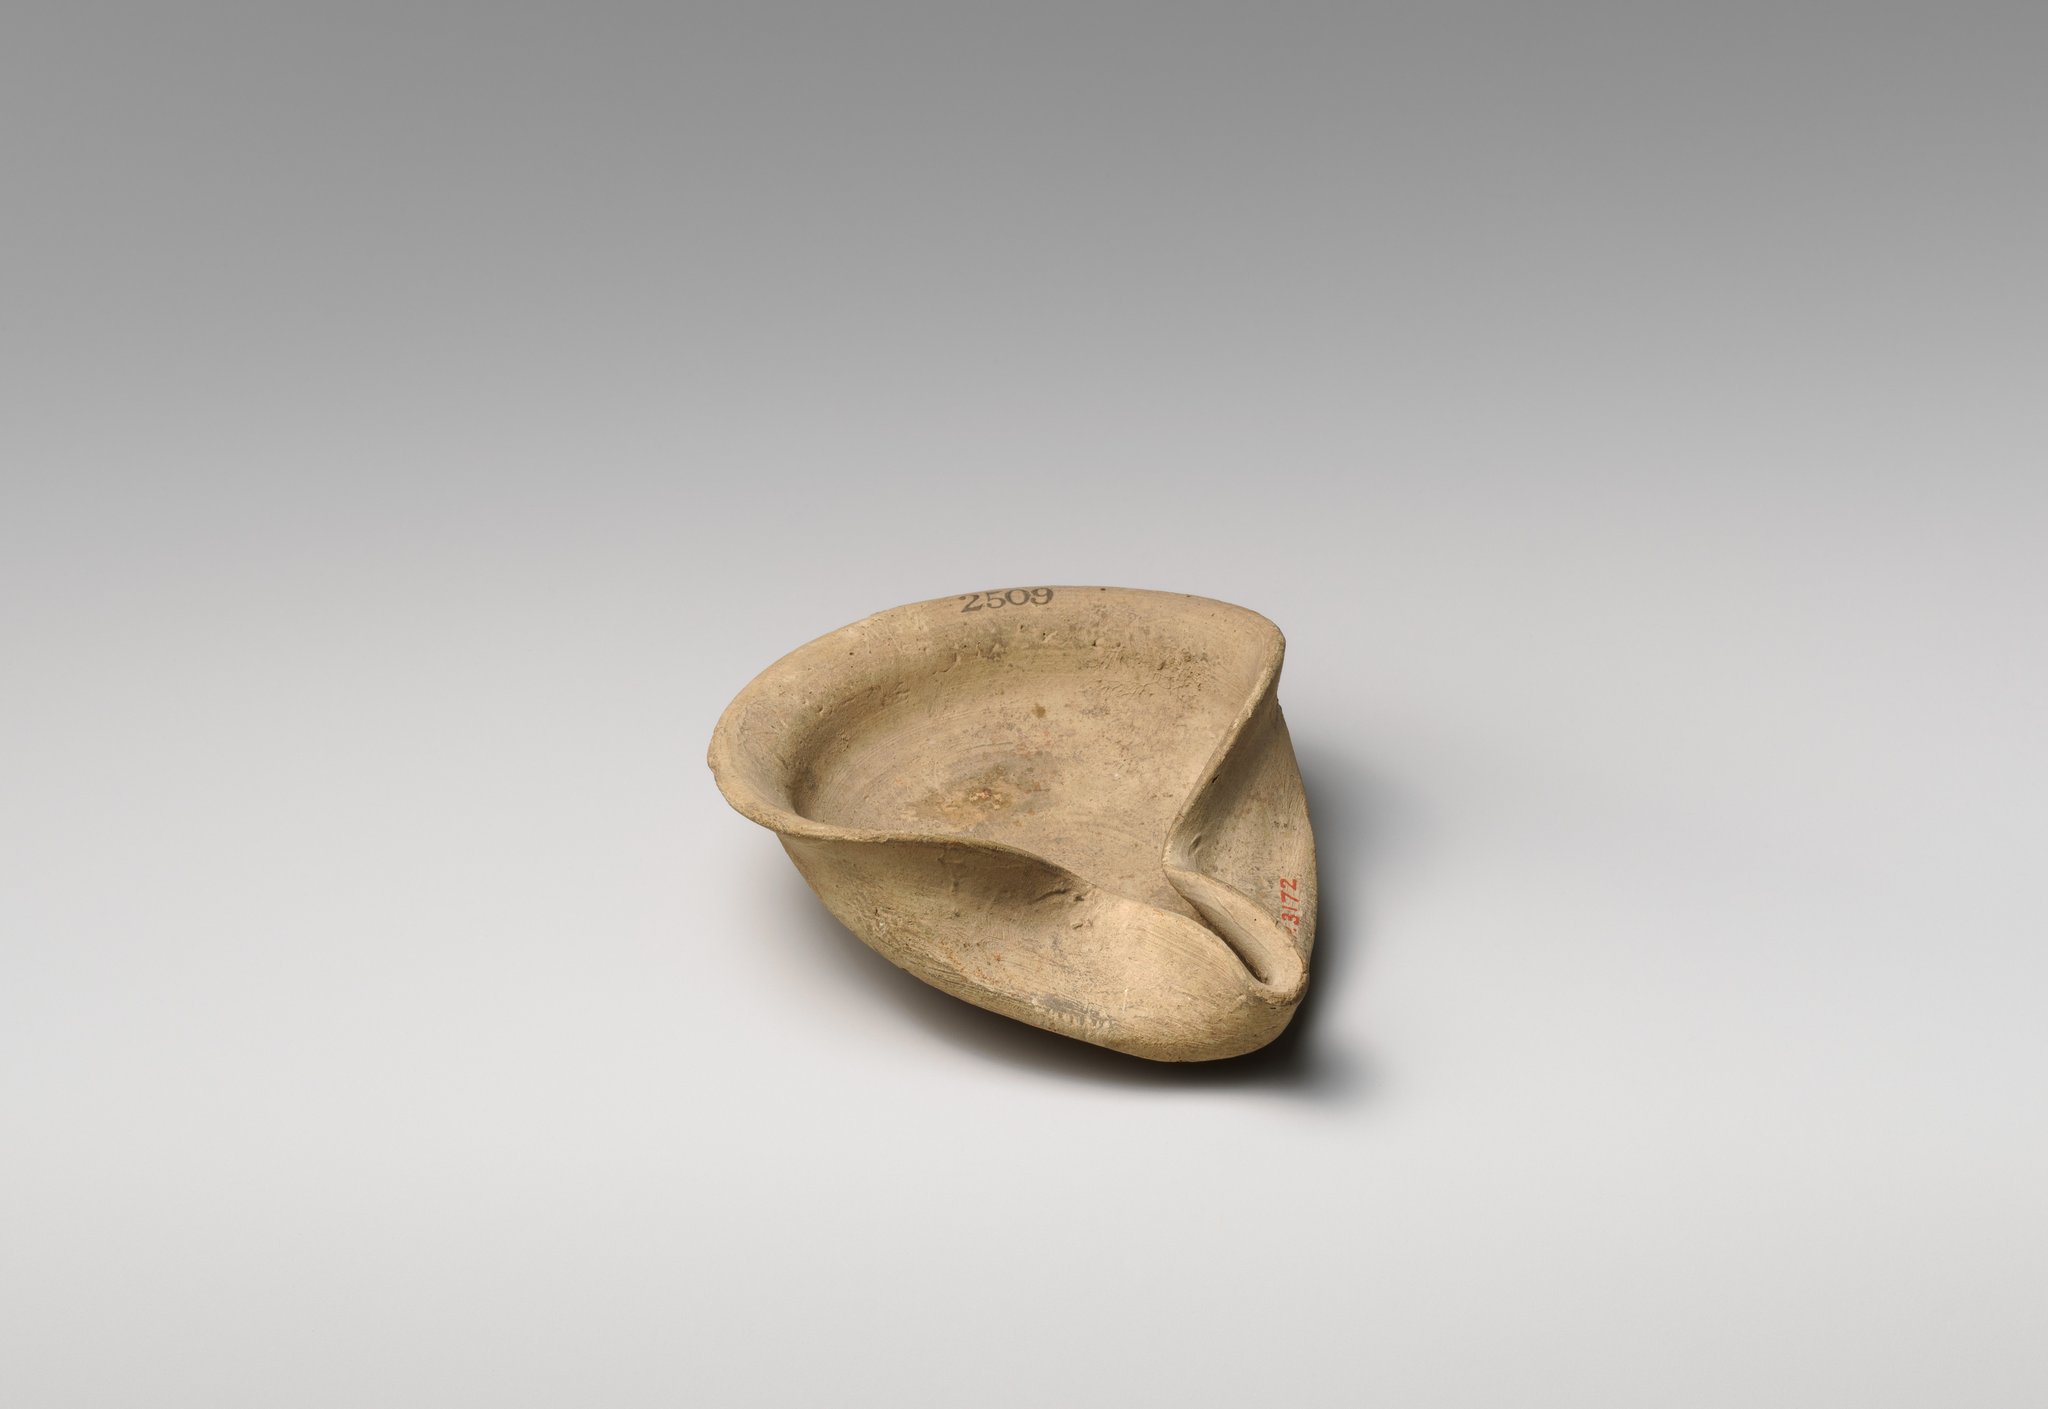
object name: lamp, saucer shaped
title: Terracotta saucer-shaped lamp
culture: cypriot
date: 400-301 BCE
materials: terracotta